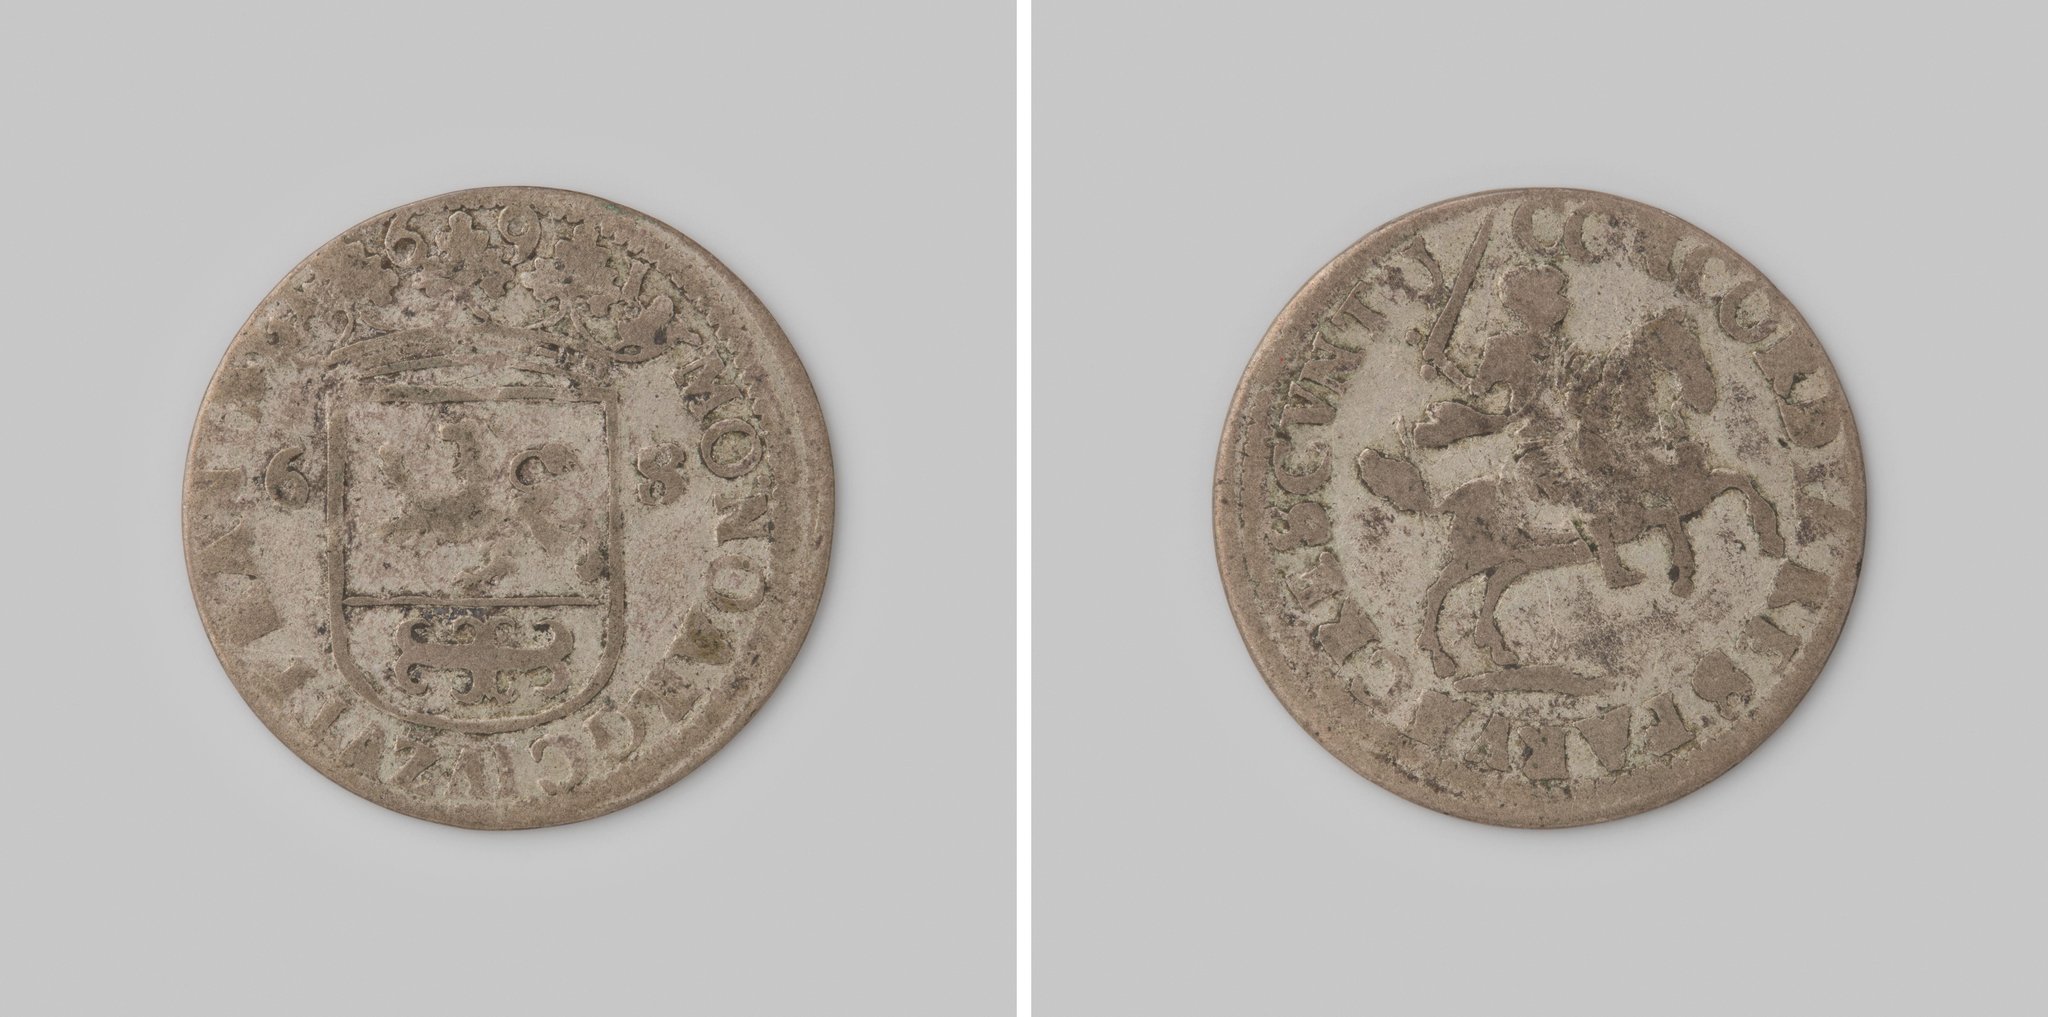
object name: coin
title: Zutphense ruiterschelling, 1691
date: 1691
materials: silver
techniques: striking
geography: zutphen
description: Zilveren munt. Voorzijde: tussen waarde-aanduiding 6 S gekroond wapenschild van Zutphen. Naast de kroon tweecijferig jaartal. Keerzijde: ridder te paard naar rechts rijdend.